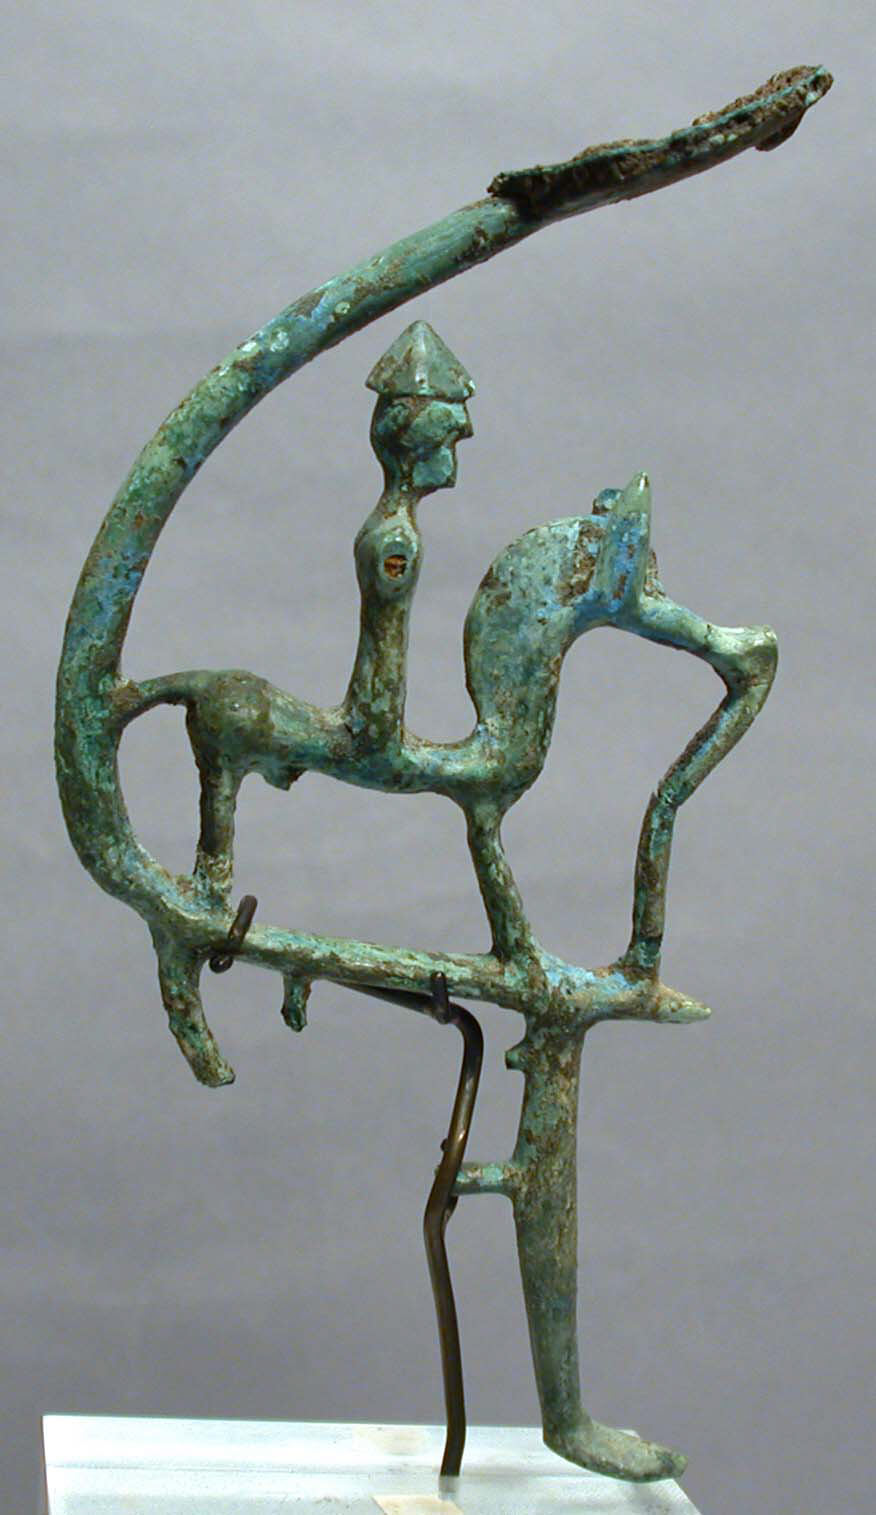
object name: leg of a cauldron with horseman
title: Bronze leg of a cauldron with horseman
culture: italic, villanovan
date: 734-701 BCE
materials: bronze